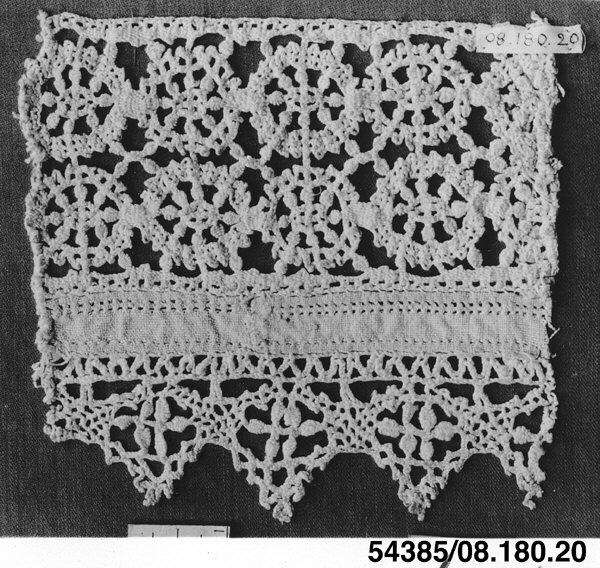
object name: fragment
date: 1701-1800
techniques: lace